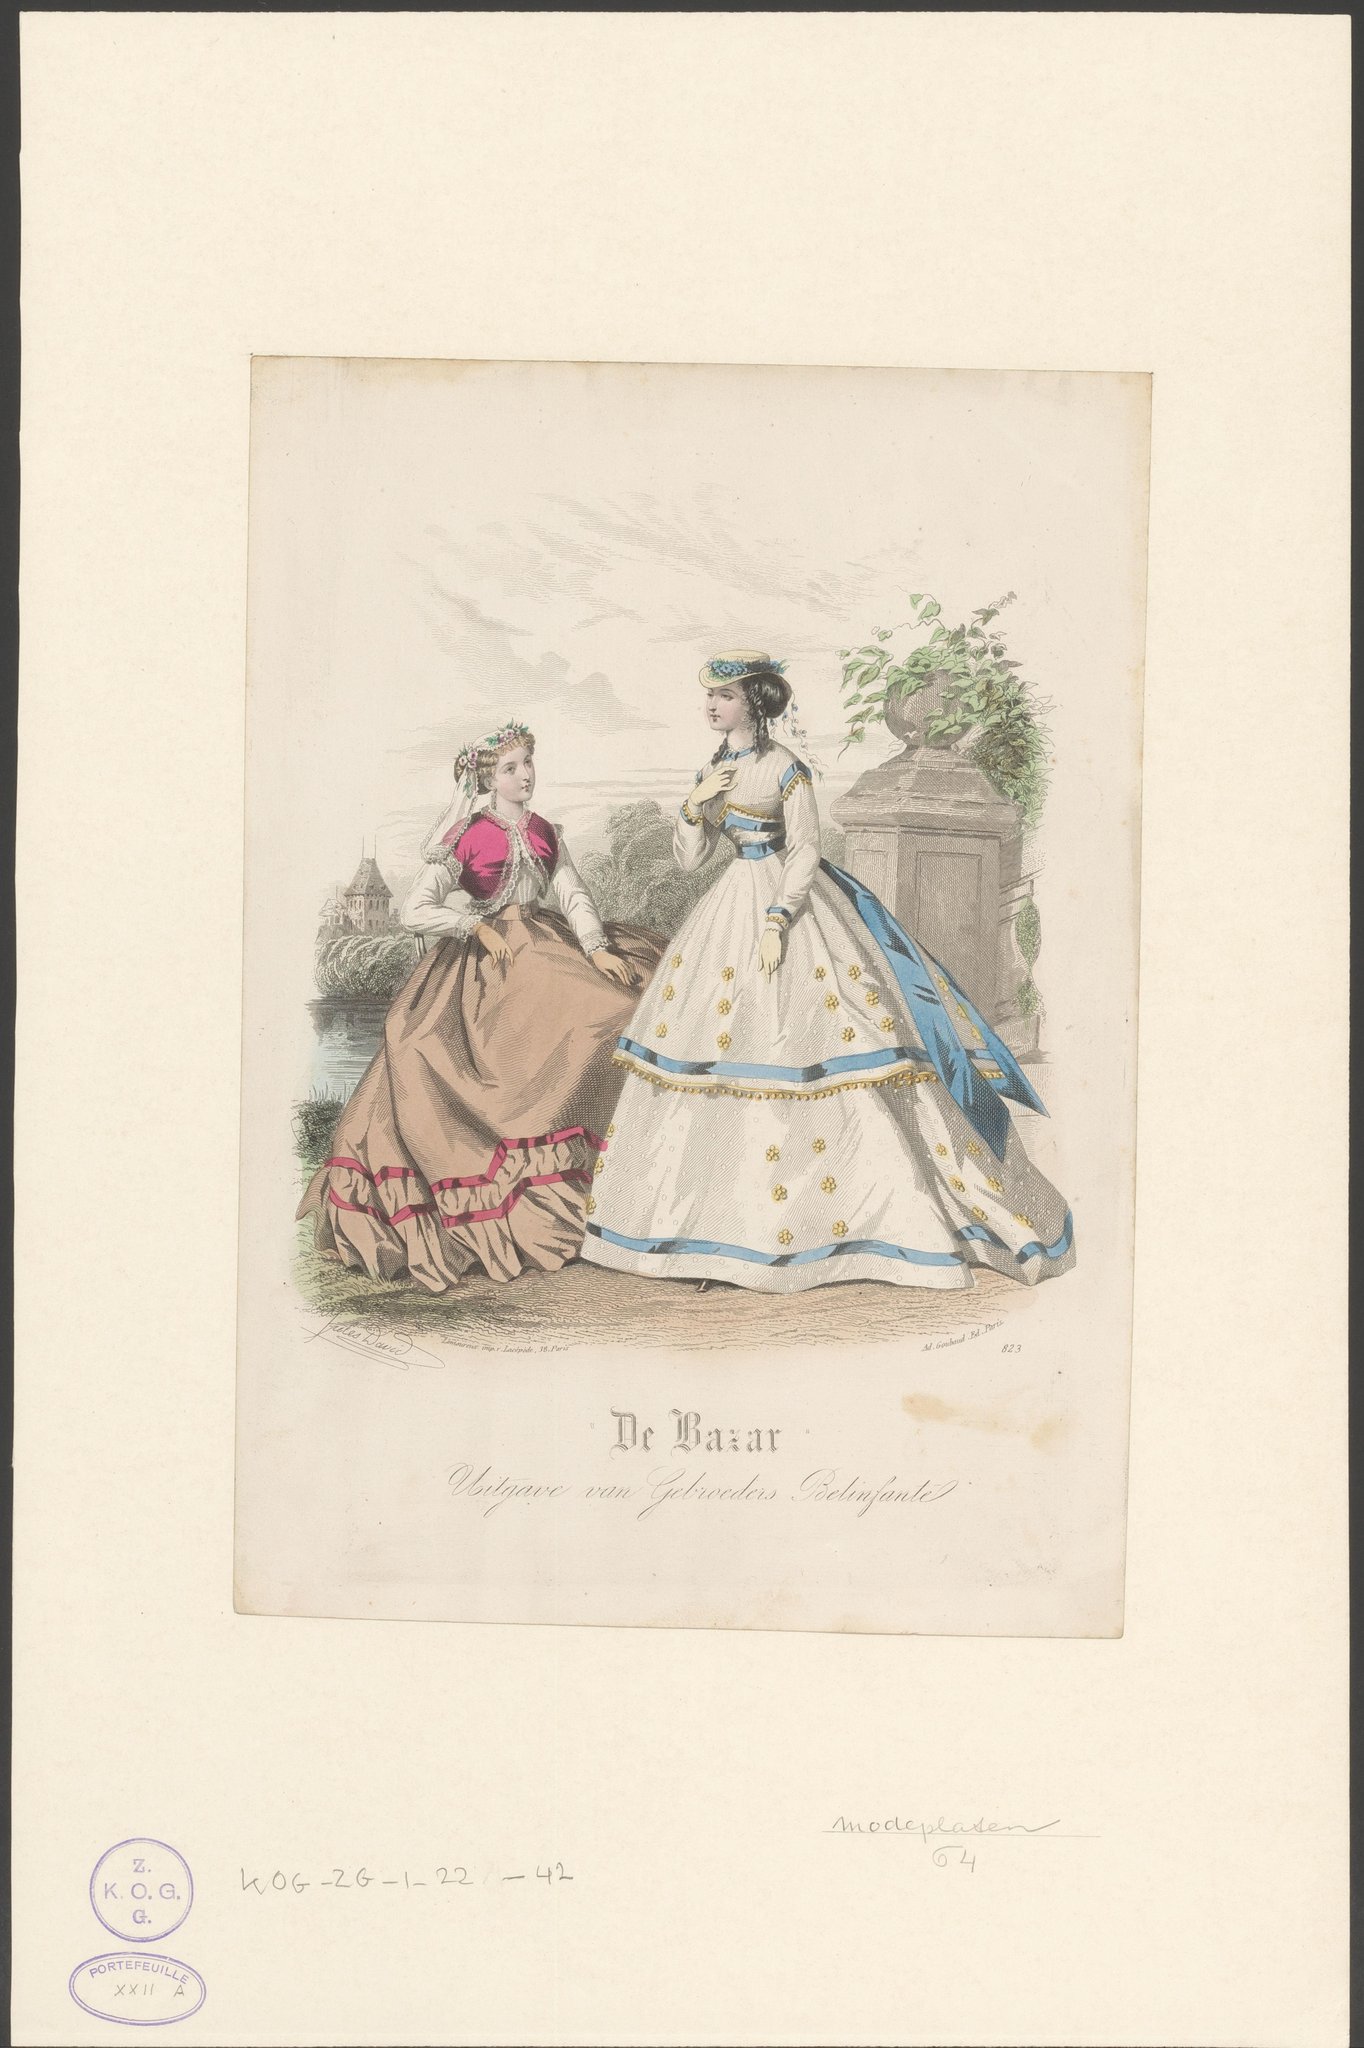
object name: fashion print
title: Twee vrouwen aan de waterkant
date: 1887-1890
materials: paper, watercolor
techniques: hand coloring, engraving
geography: the hague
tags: fashion plates, clothes, costume (+ women's clothes), dress, gown (+ women's clothes)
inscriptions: collector's mark, collector's mark: Lugt 1641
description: Twee vrouwen, bij de waterkant. Prent uit het modetijdschrift De Bazar, geïllustreerd Tijdschrift voor Modes en Handwerken (1857-1900). Onderwerpsrubrieken binnen de Atlas Zeden en Gewoonten: De Kleeding, Modeplaten.